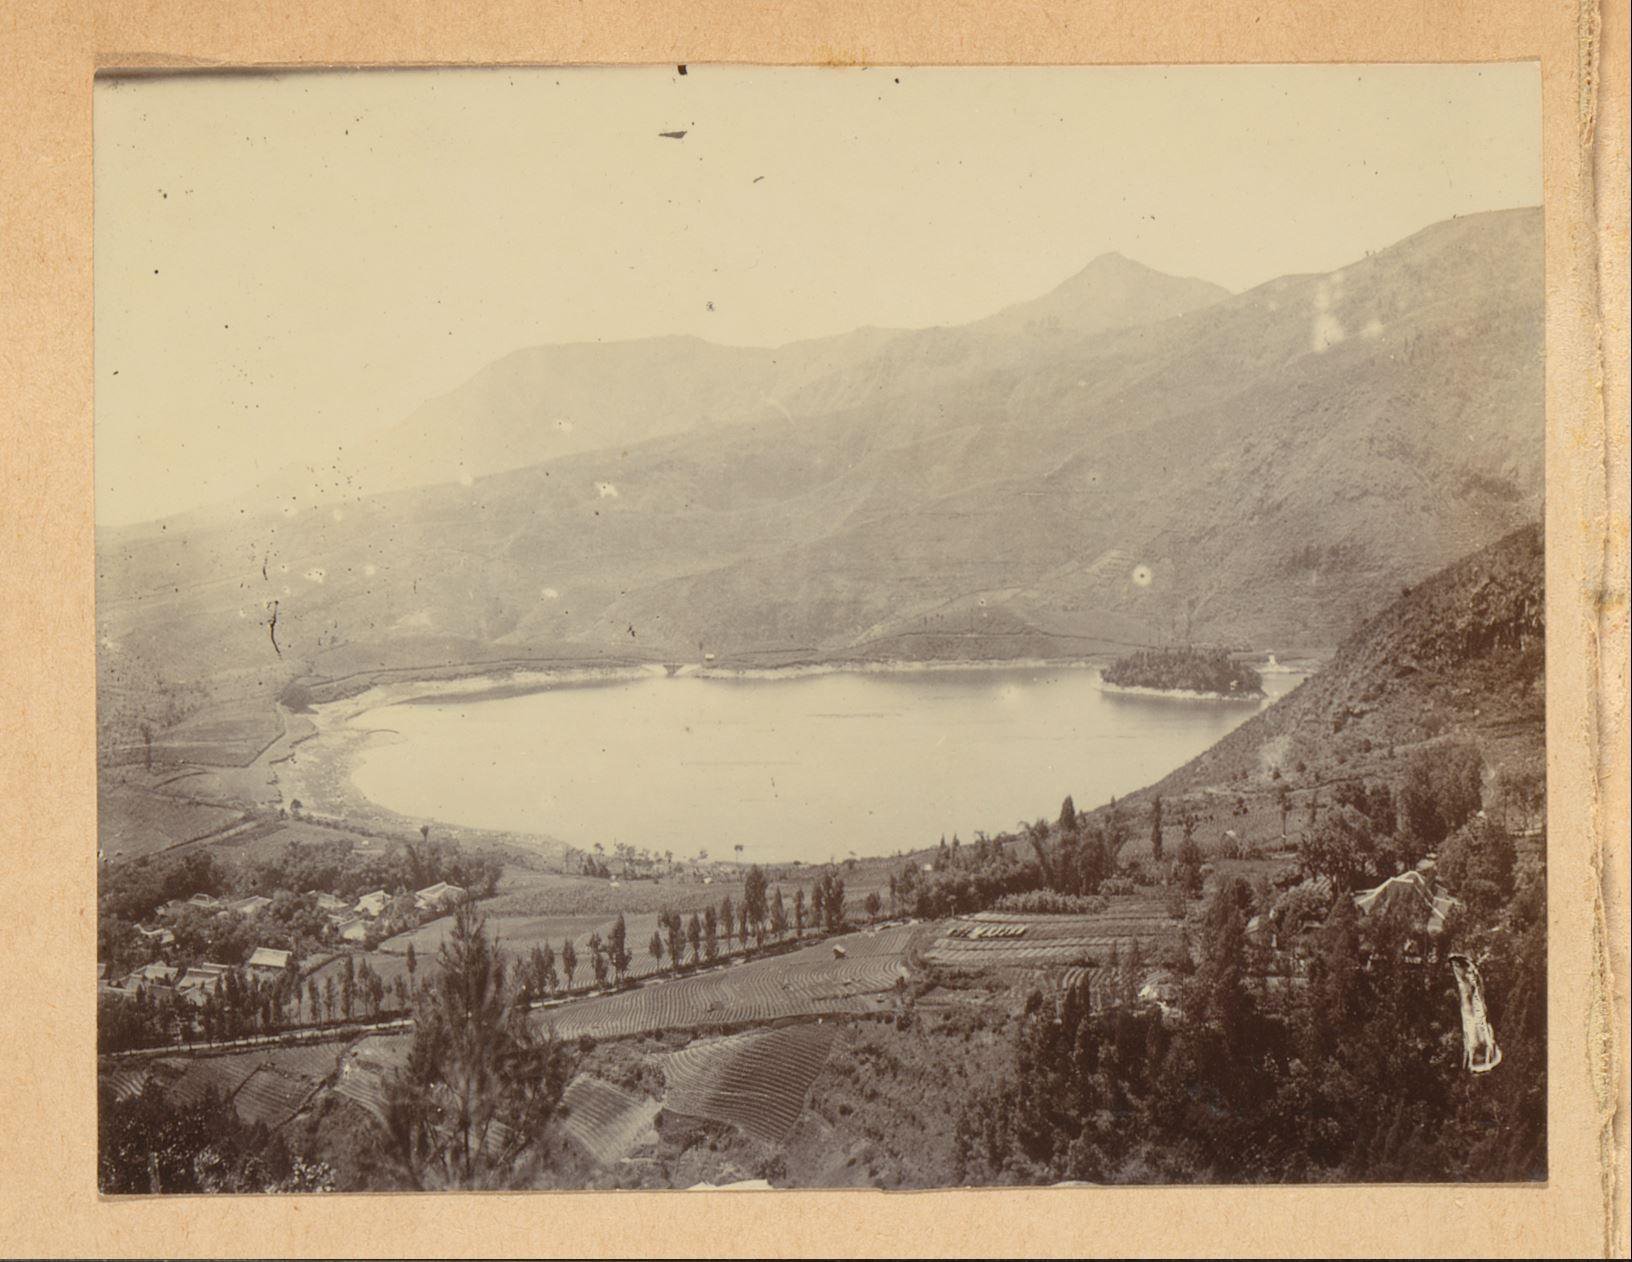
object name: photograph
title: Gezicht op een kratermeer in Nederlands-Indië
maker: Anonymous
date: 1917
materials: photographic support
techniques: gelatin silver print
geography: dutch east indies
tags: lake, volcano, dutch east indies, the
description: Onderdeel van Familiealbum met foto's van een familie in de voormalige kolonie Nederlands-Indië en van een suikerfabriek in Purworejo.